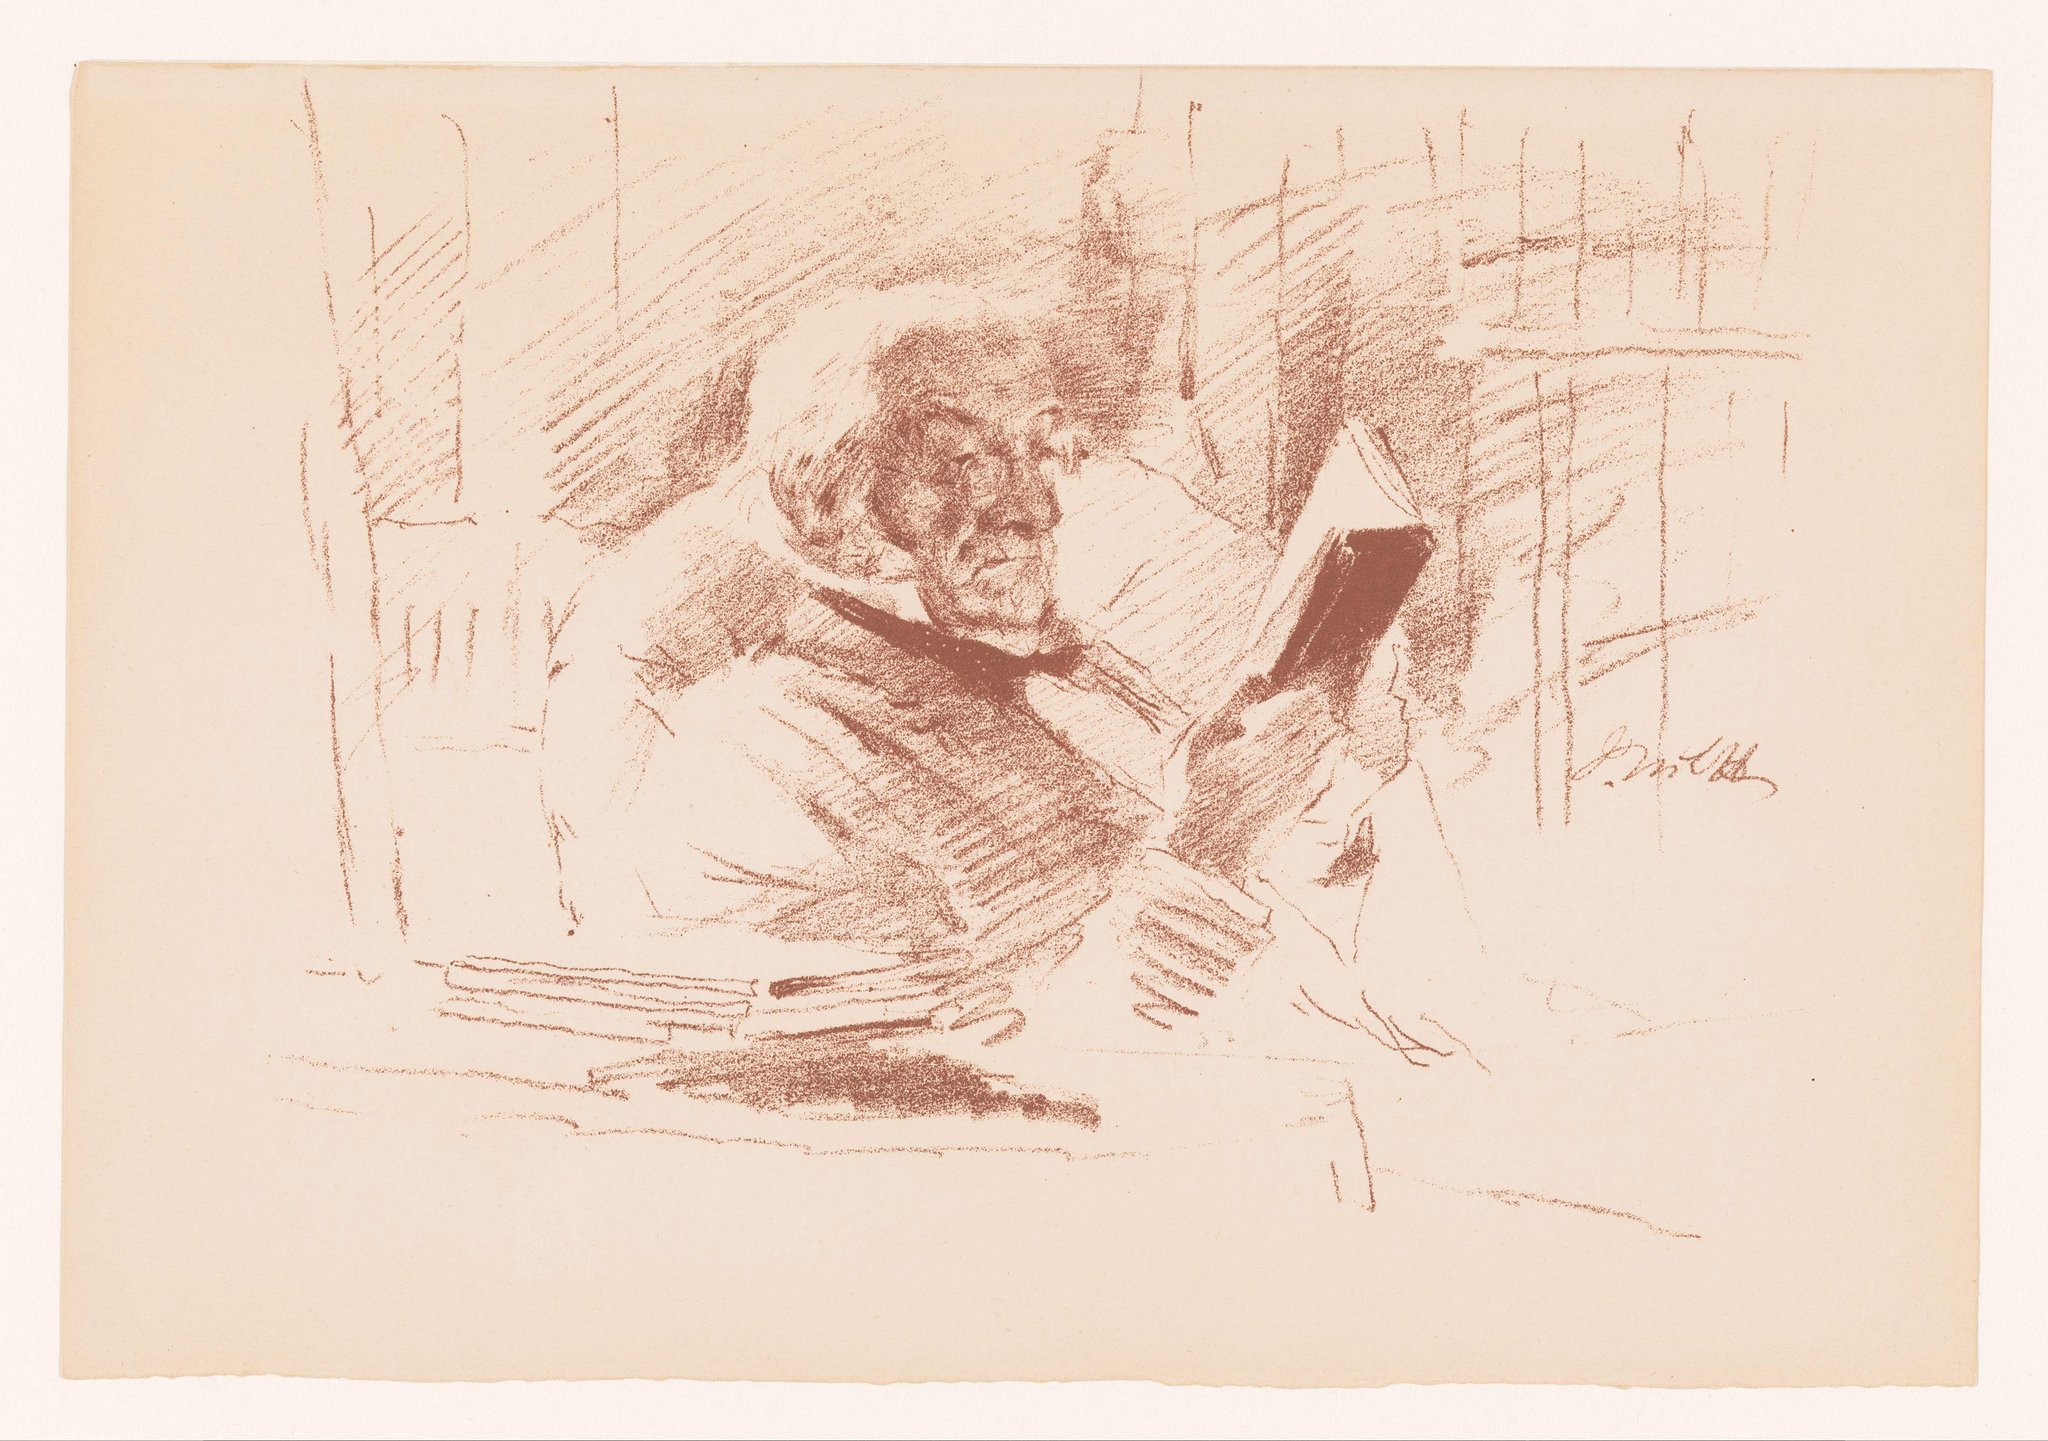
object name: print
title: Portret van Mr. Gladstone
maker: john mc lure hamilton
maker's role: print maker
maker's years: 1853-1936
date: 1896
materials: paper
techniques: lithography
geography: hawarden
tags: politician, reading, historical persons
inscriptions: collector's mark: Lugt 2228, signature: ‘J.MH’, check stamp: ‘The Studio London’ Lugt 2322bis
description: Prent gebruikt voor: The studio : an illustrated magazine of fine and applied art, vol. 14 (1898), p. 134.